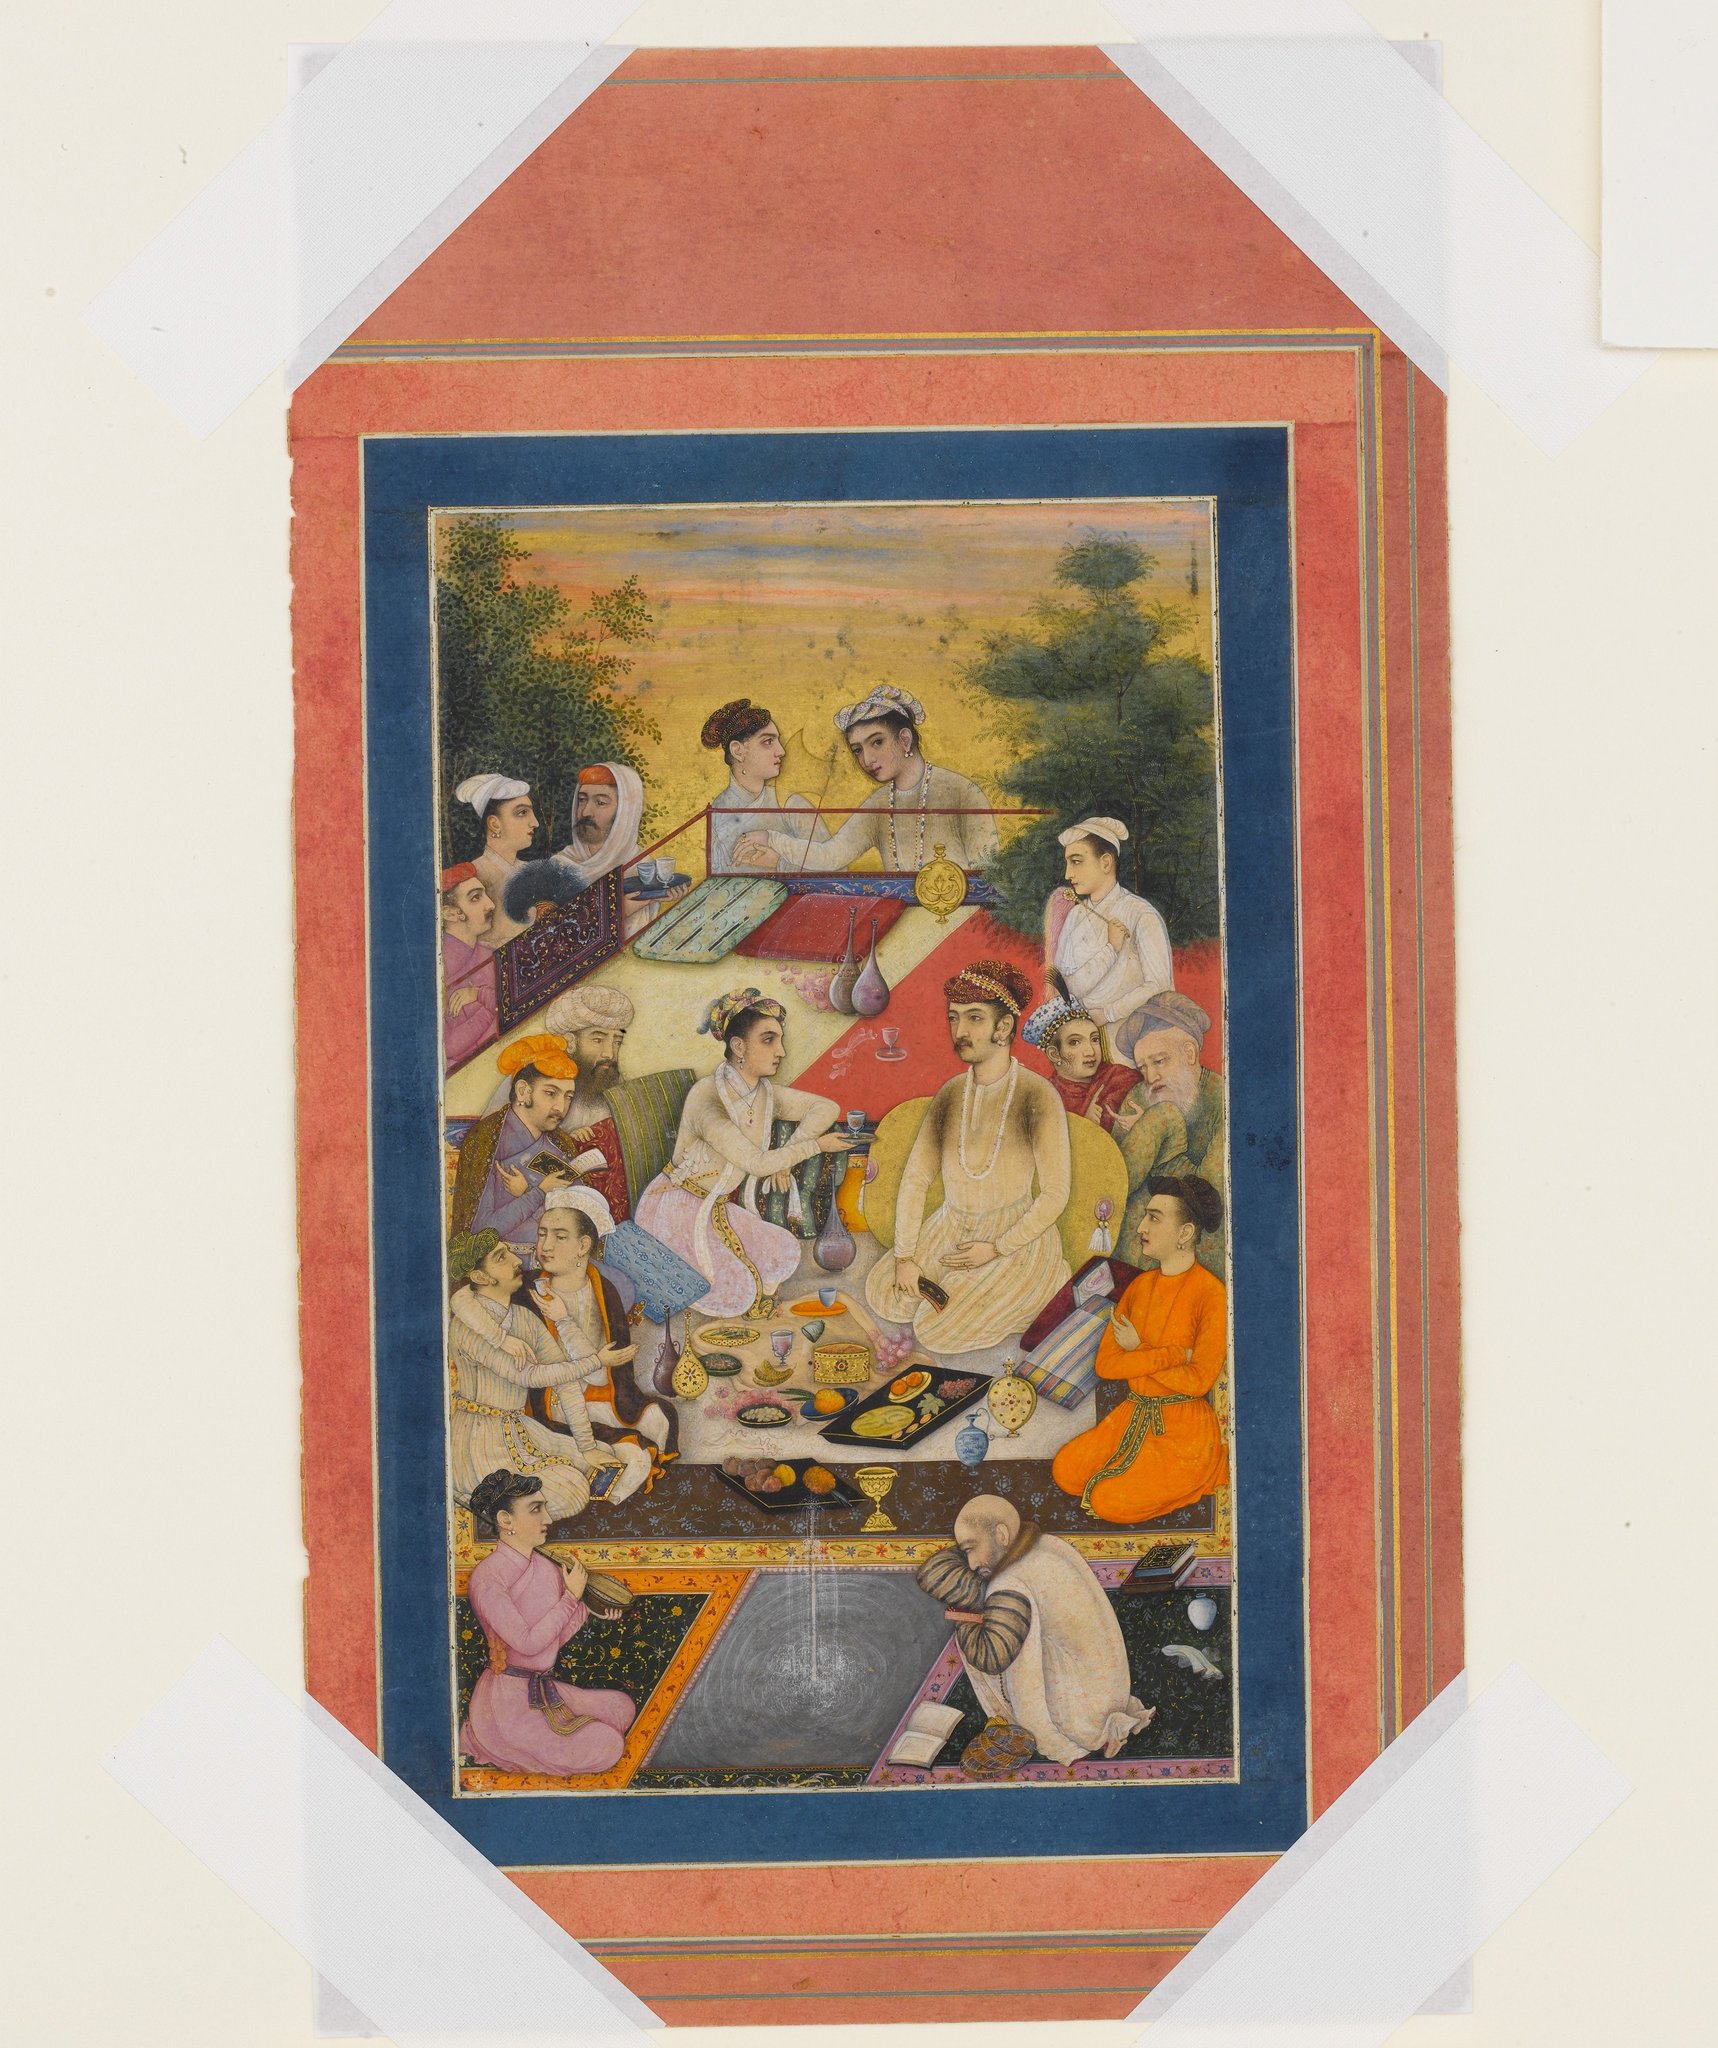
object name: illustrated album leaf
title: "Prince Feasting on a Balcony", Folio from the Davis Album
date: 1667-1733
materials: gold, ink, paper, watercolor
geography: india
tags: food,musical instruments,princes,men,women,dining